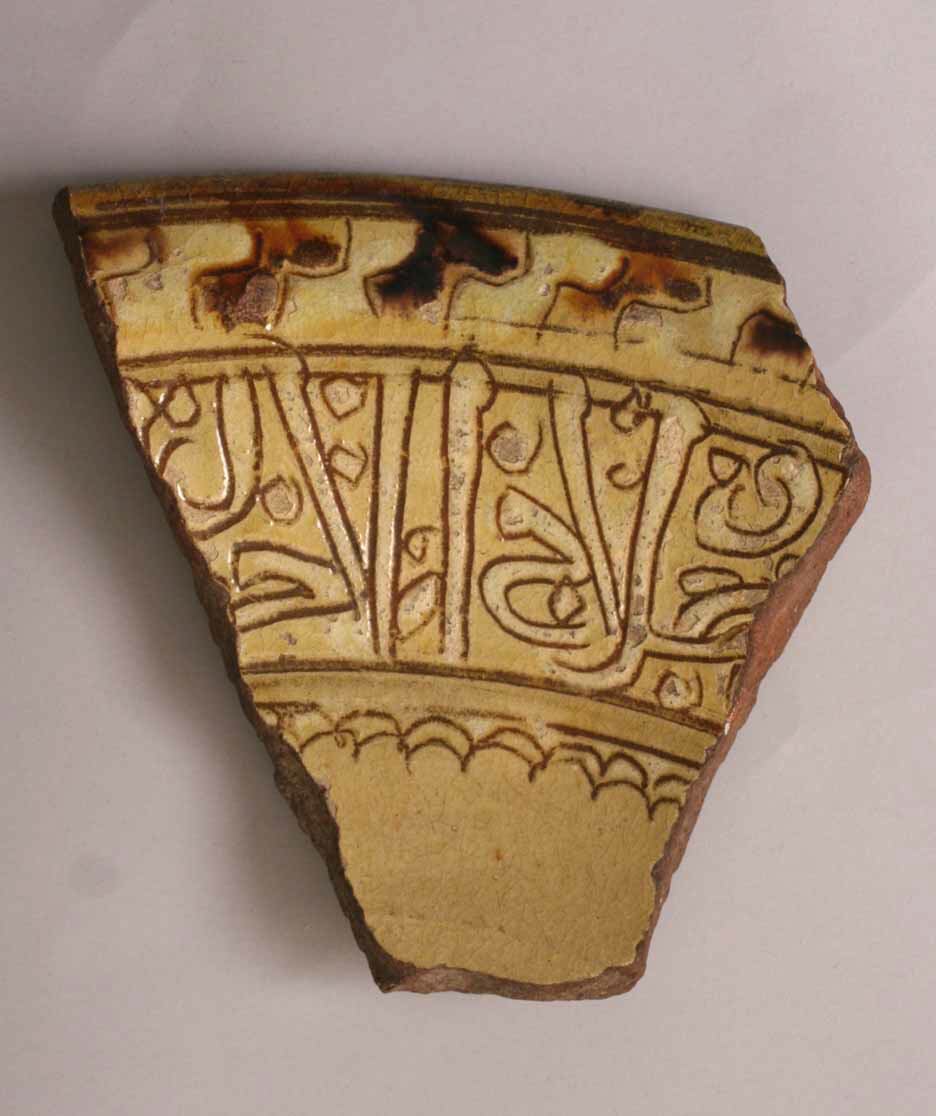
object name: ceramic fragment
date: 1301-1500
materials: earthenware, glaze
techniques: coloring, incising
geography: egypt